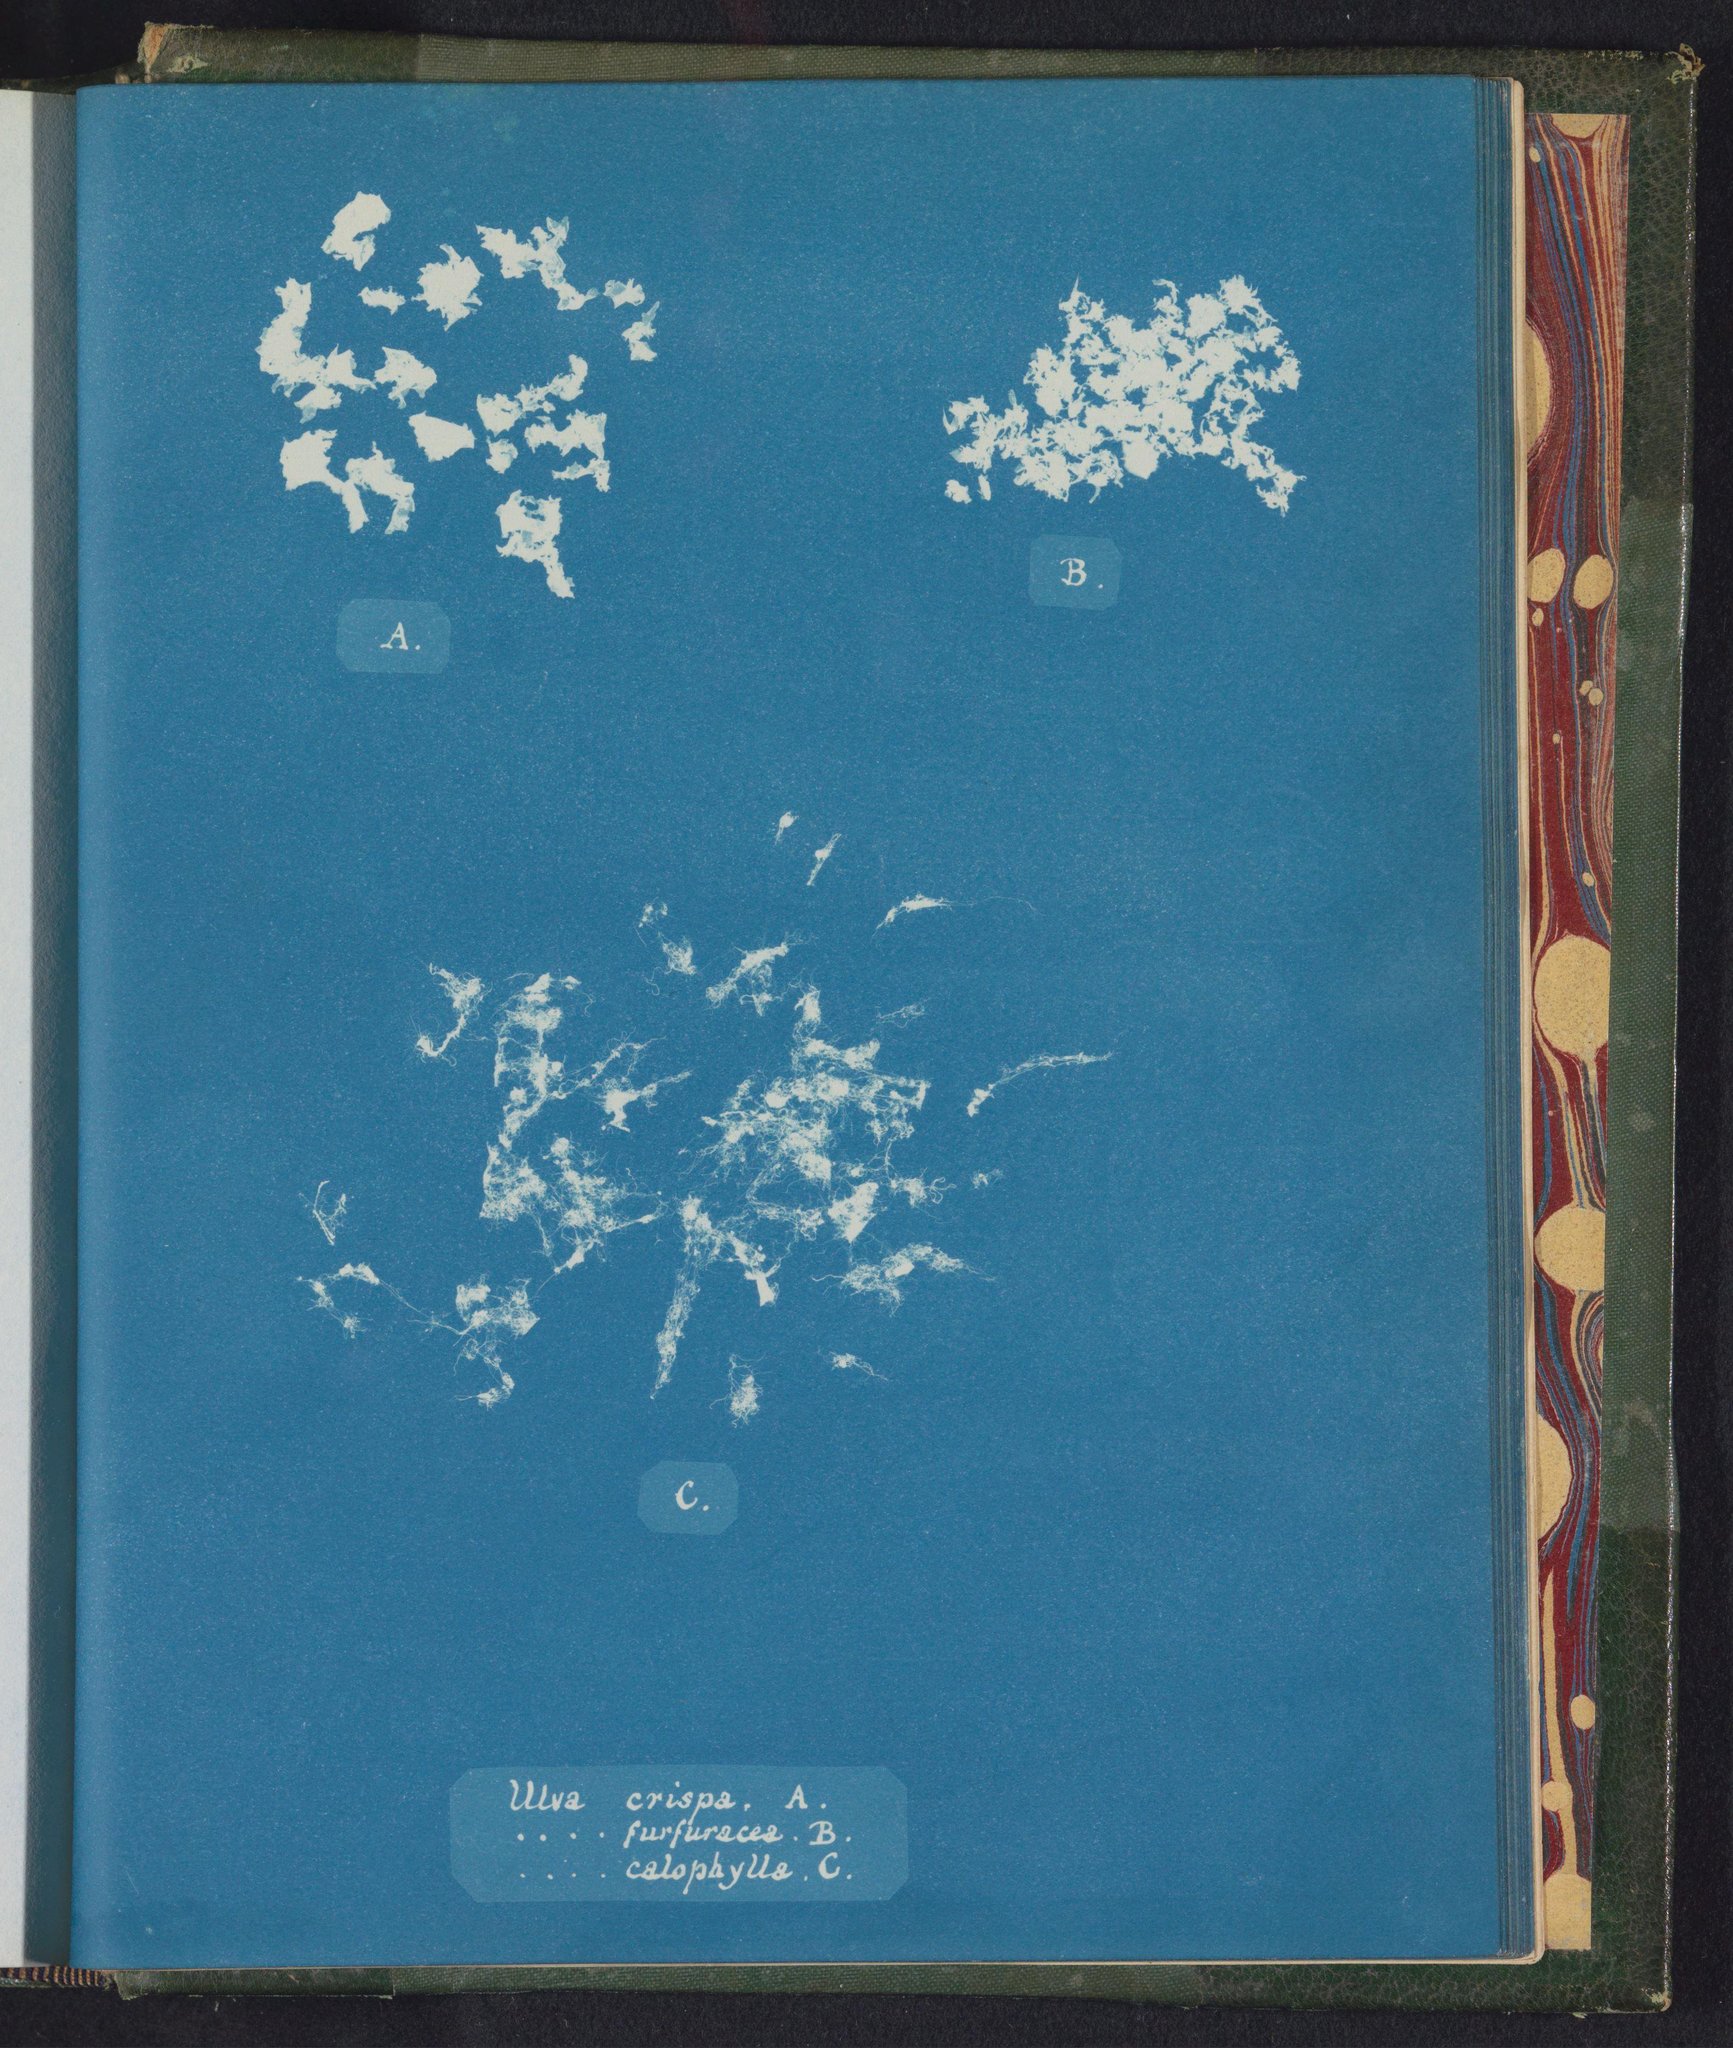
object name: photograph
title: Zeewier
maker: anna atkins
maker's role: fotograaf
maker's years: 1799-1871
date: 1843-1853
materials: photographic support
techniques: cyanotype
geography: united kingdom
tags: algae, seaweed